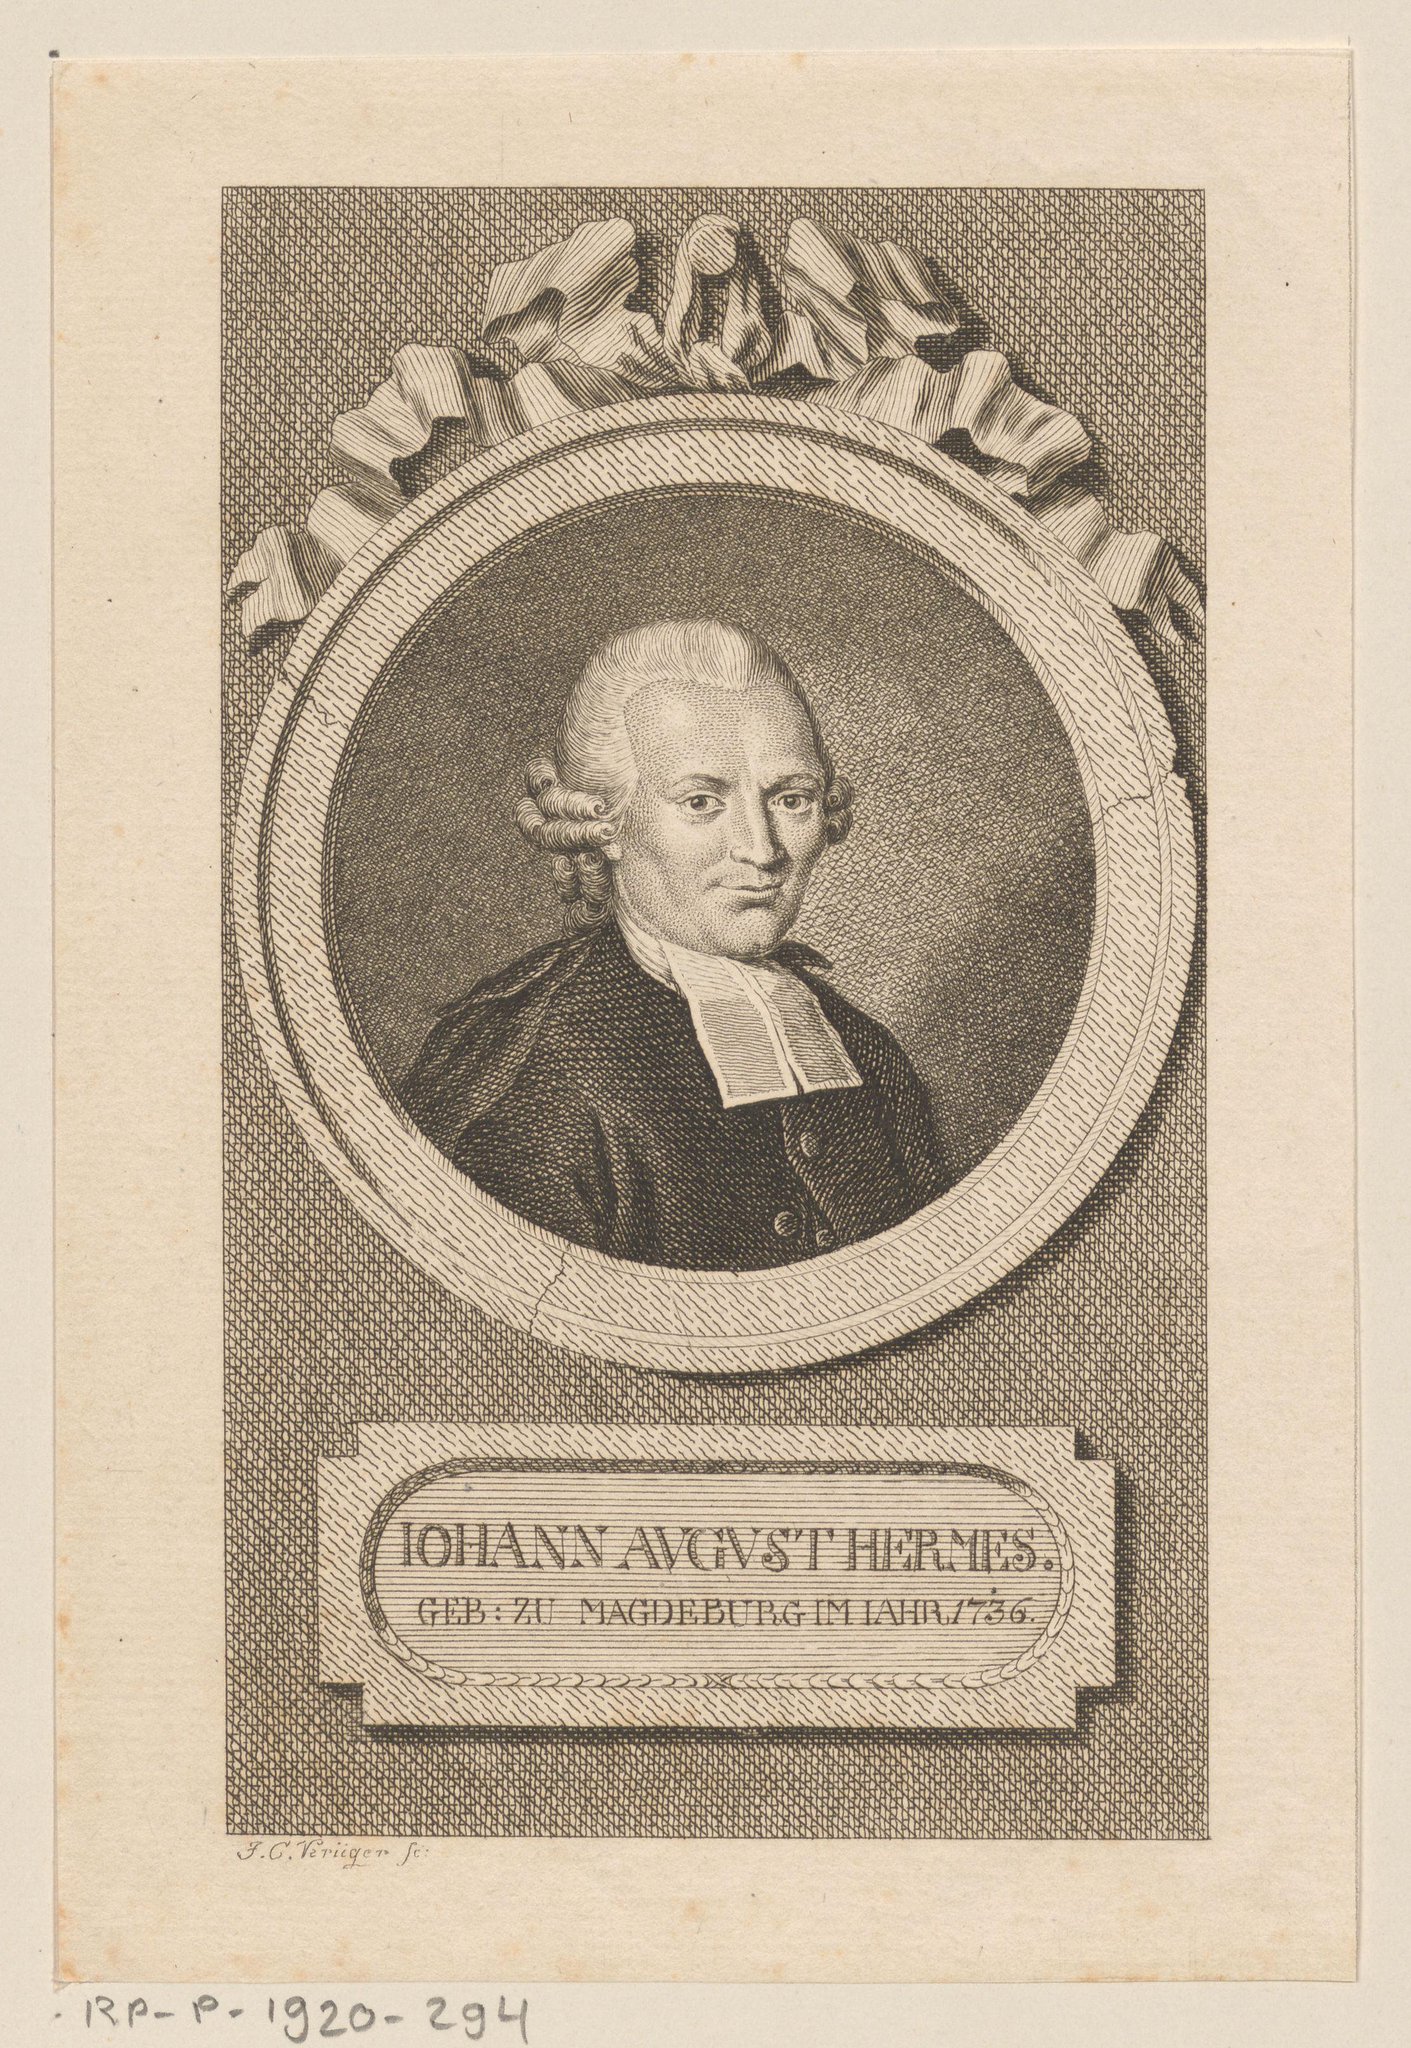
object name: print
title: Portret van Johann August Hermes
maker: johann conrad krüger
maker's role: artist, painter, print maker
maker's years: 1733-1791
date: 1755-1791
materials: paper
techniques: etching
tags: theologian, historical persons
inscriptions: collector's mark: Lugt 2228